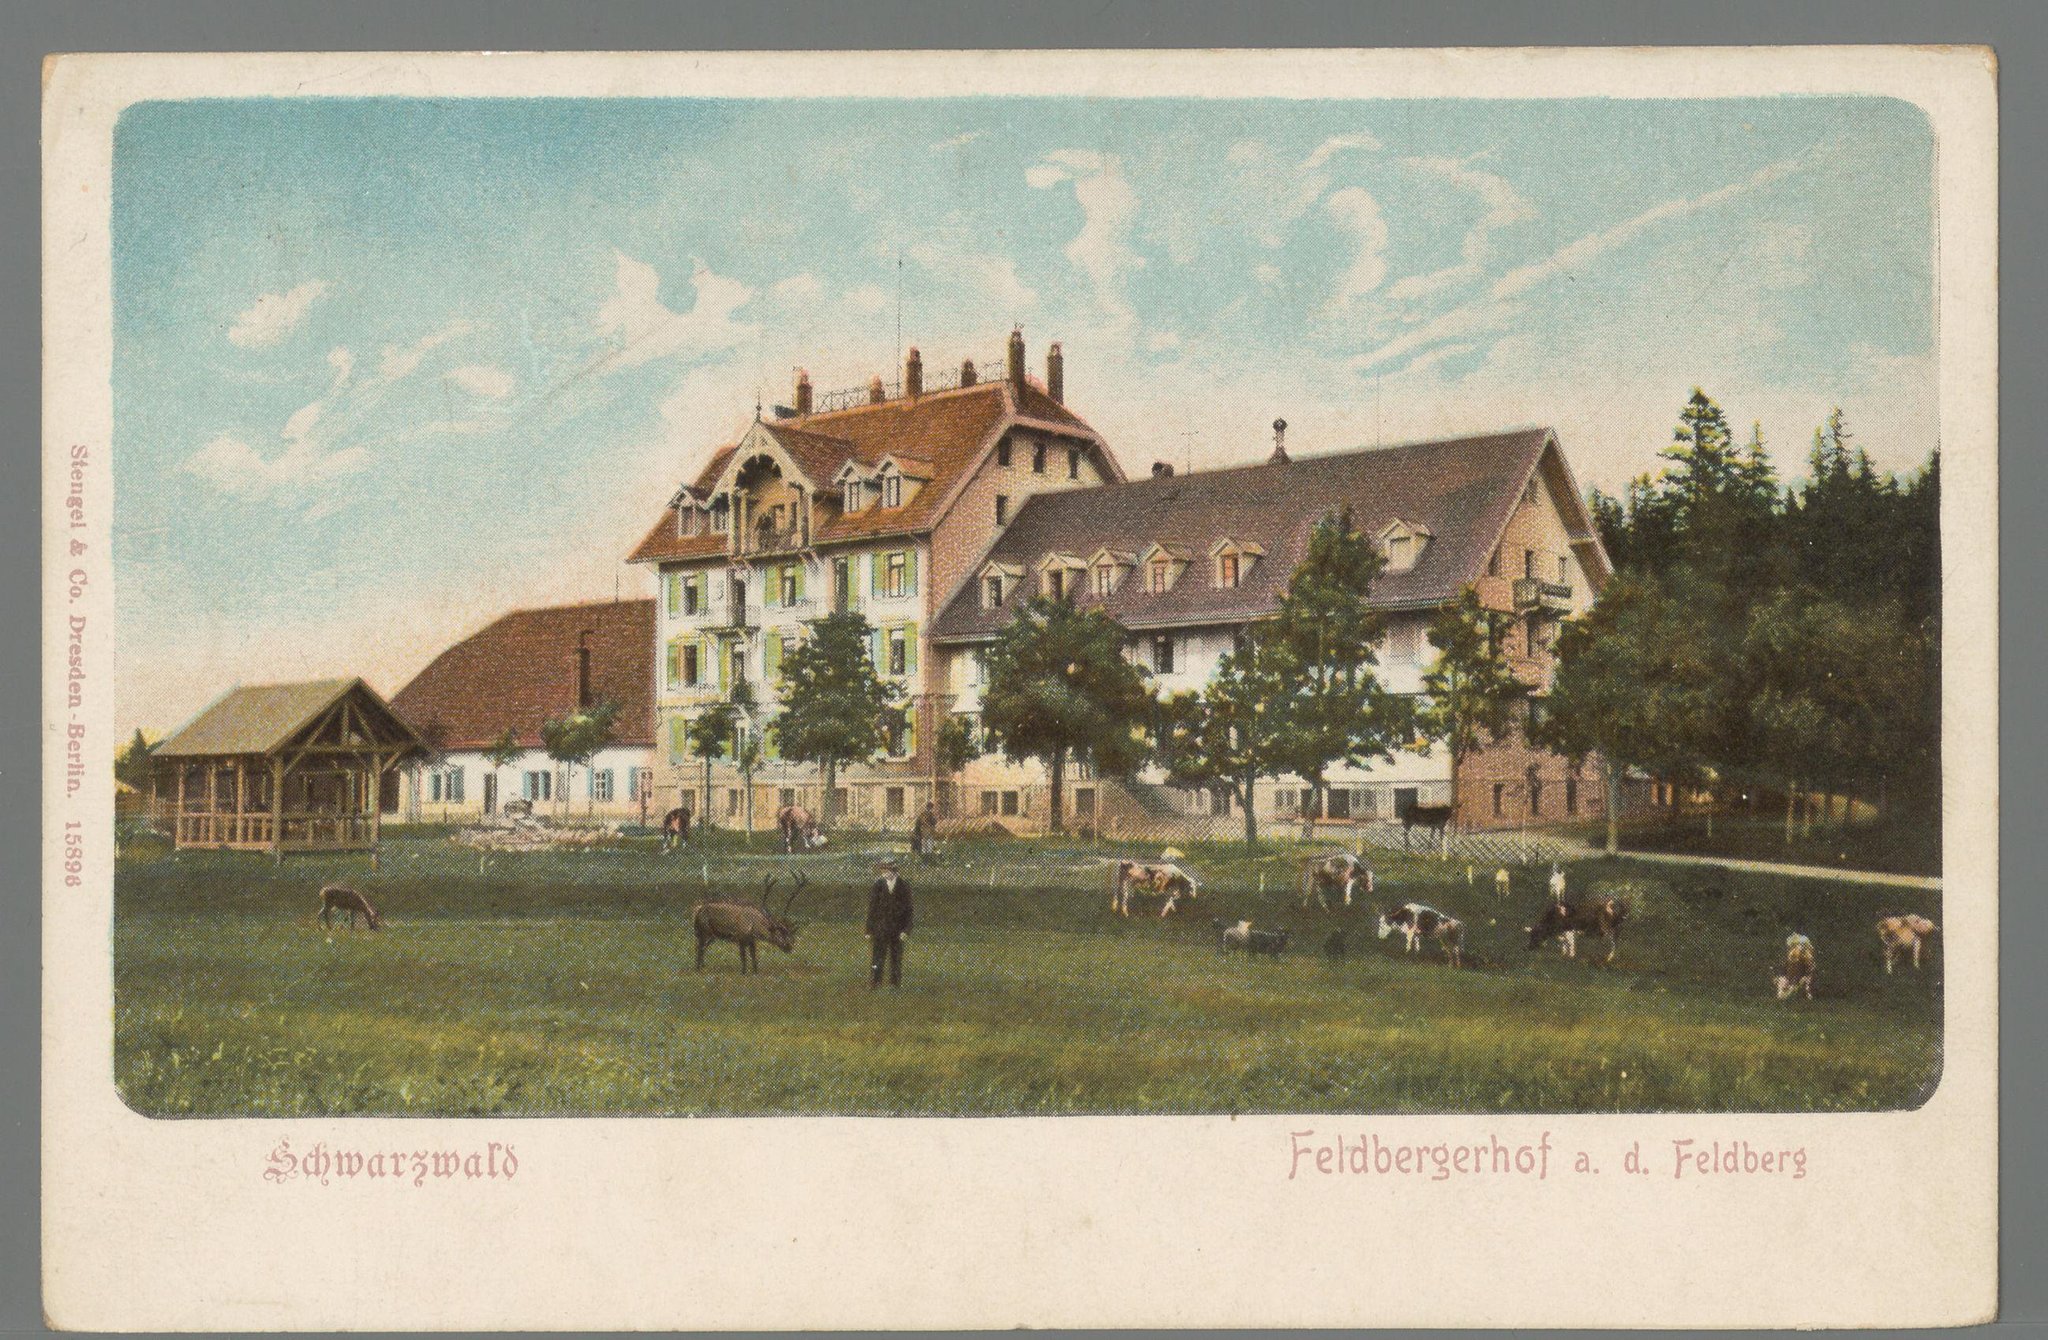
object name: photomechanical print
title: Schwarzwald. Feldbergerhof a.d. Feldberg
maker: Anonymous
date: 1889-1905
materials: cardboard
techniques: lithograph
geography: schwarzwald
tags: street